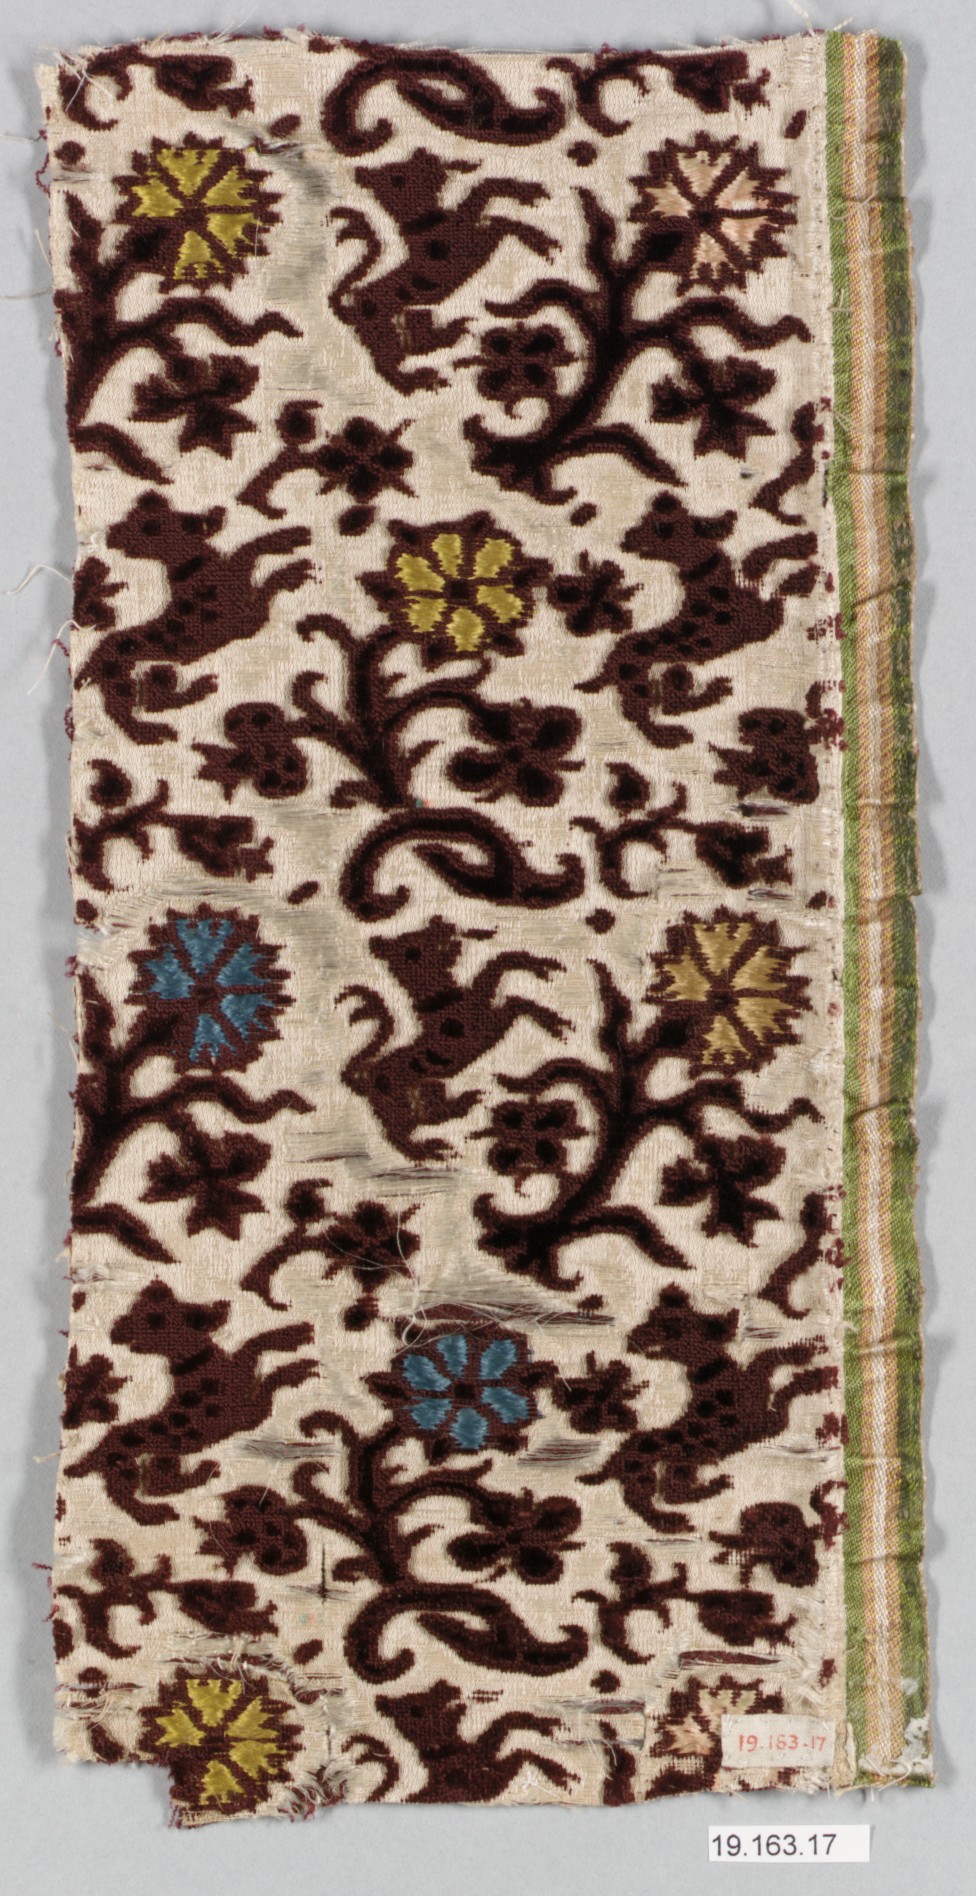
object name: fragment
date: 1601-1633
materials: silk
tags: animals,flowers